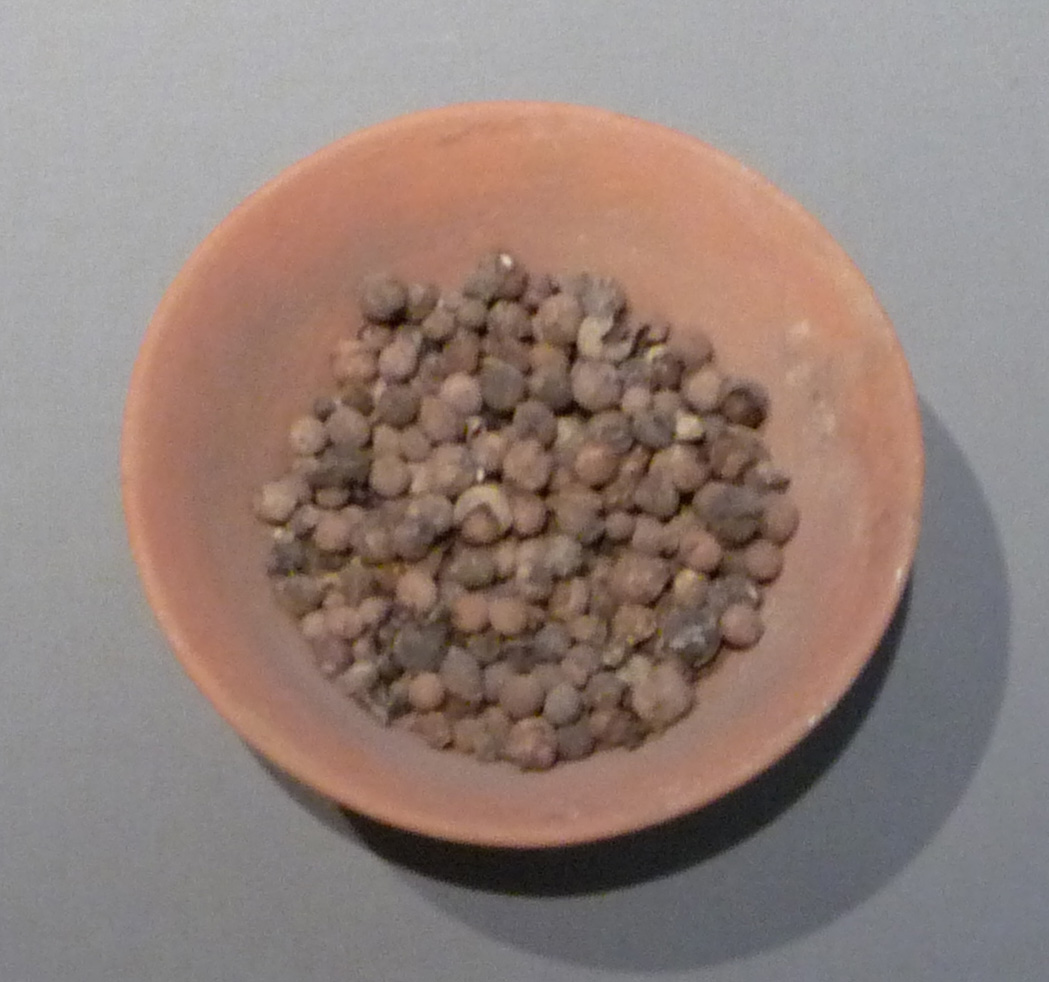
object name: bowl, jujube, foundation deposit, hatshepsut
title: Bowl of Jujubes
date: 1479-1458 BCE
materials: pottery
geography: egypt